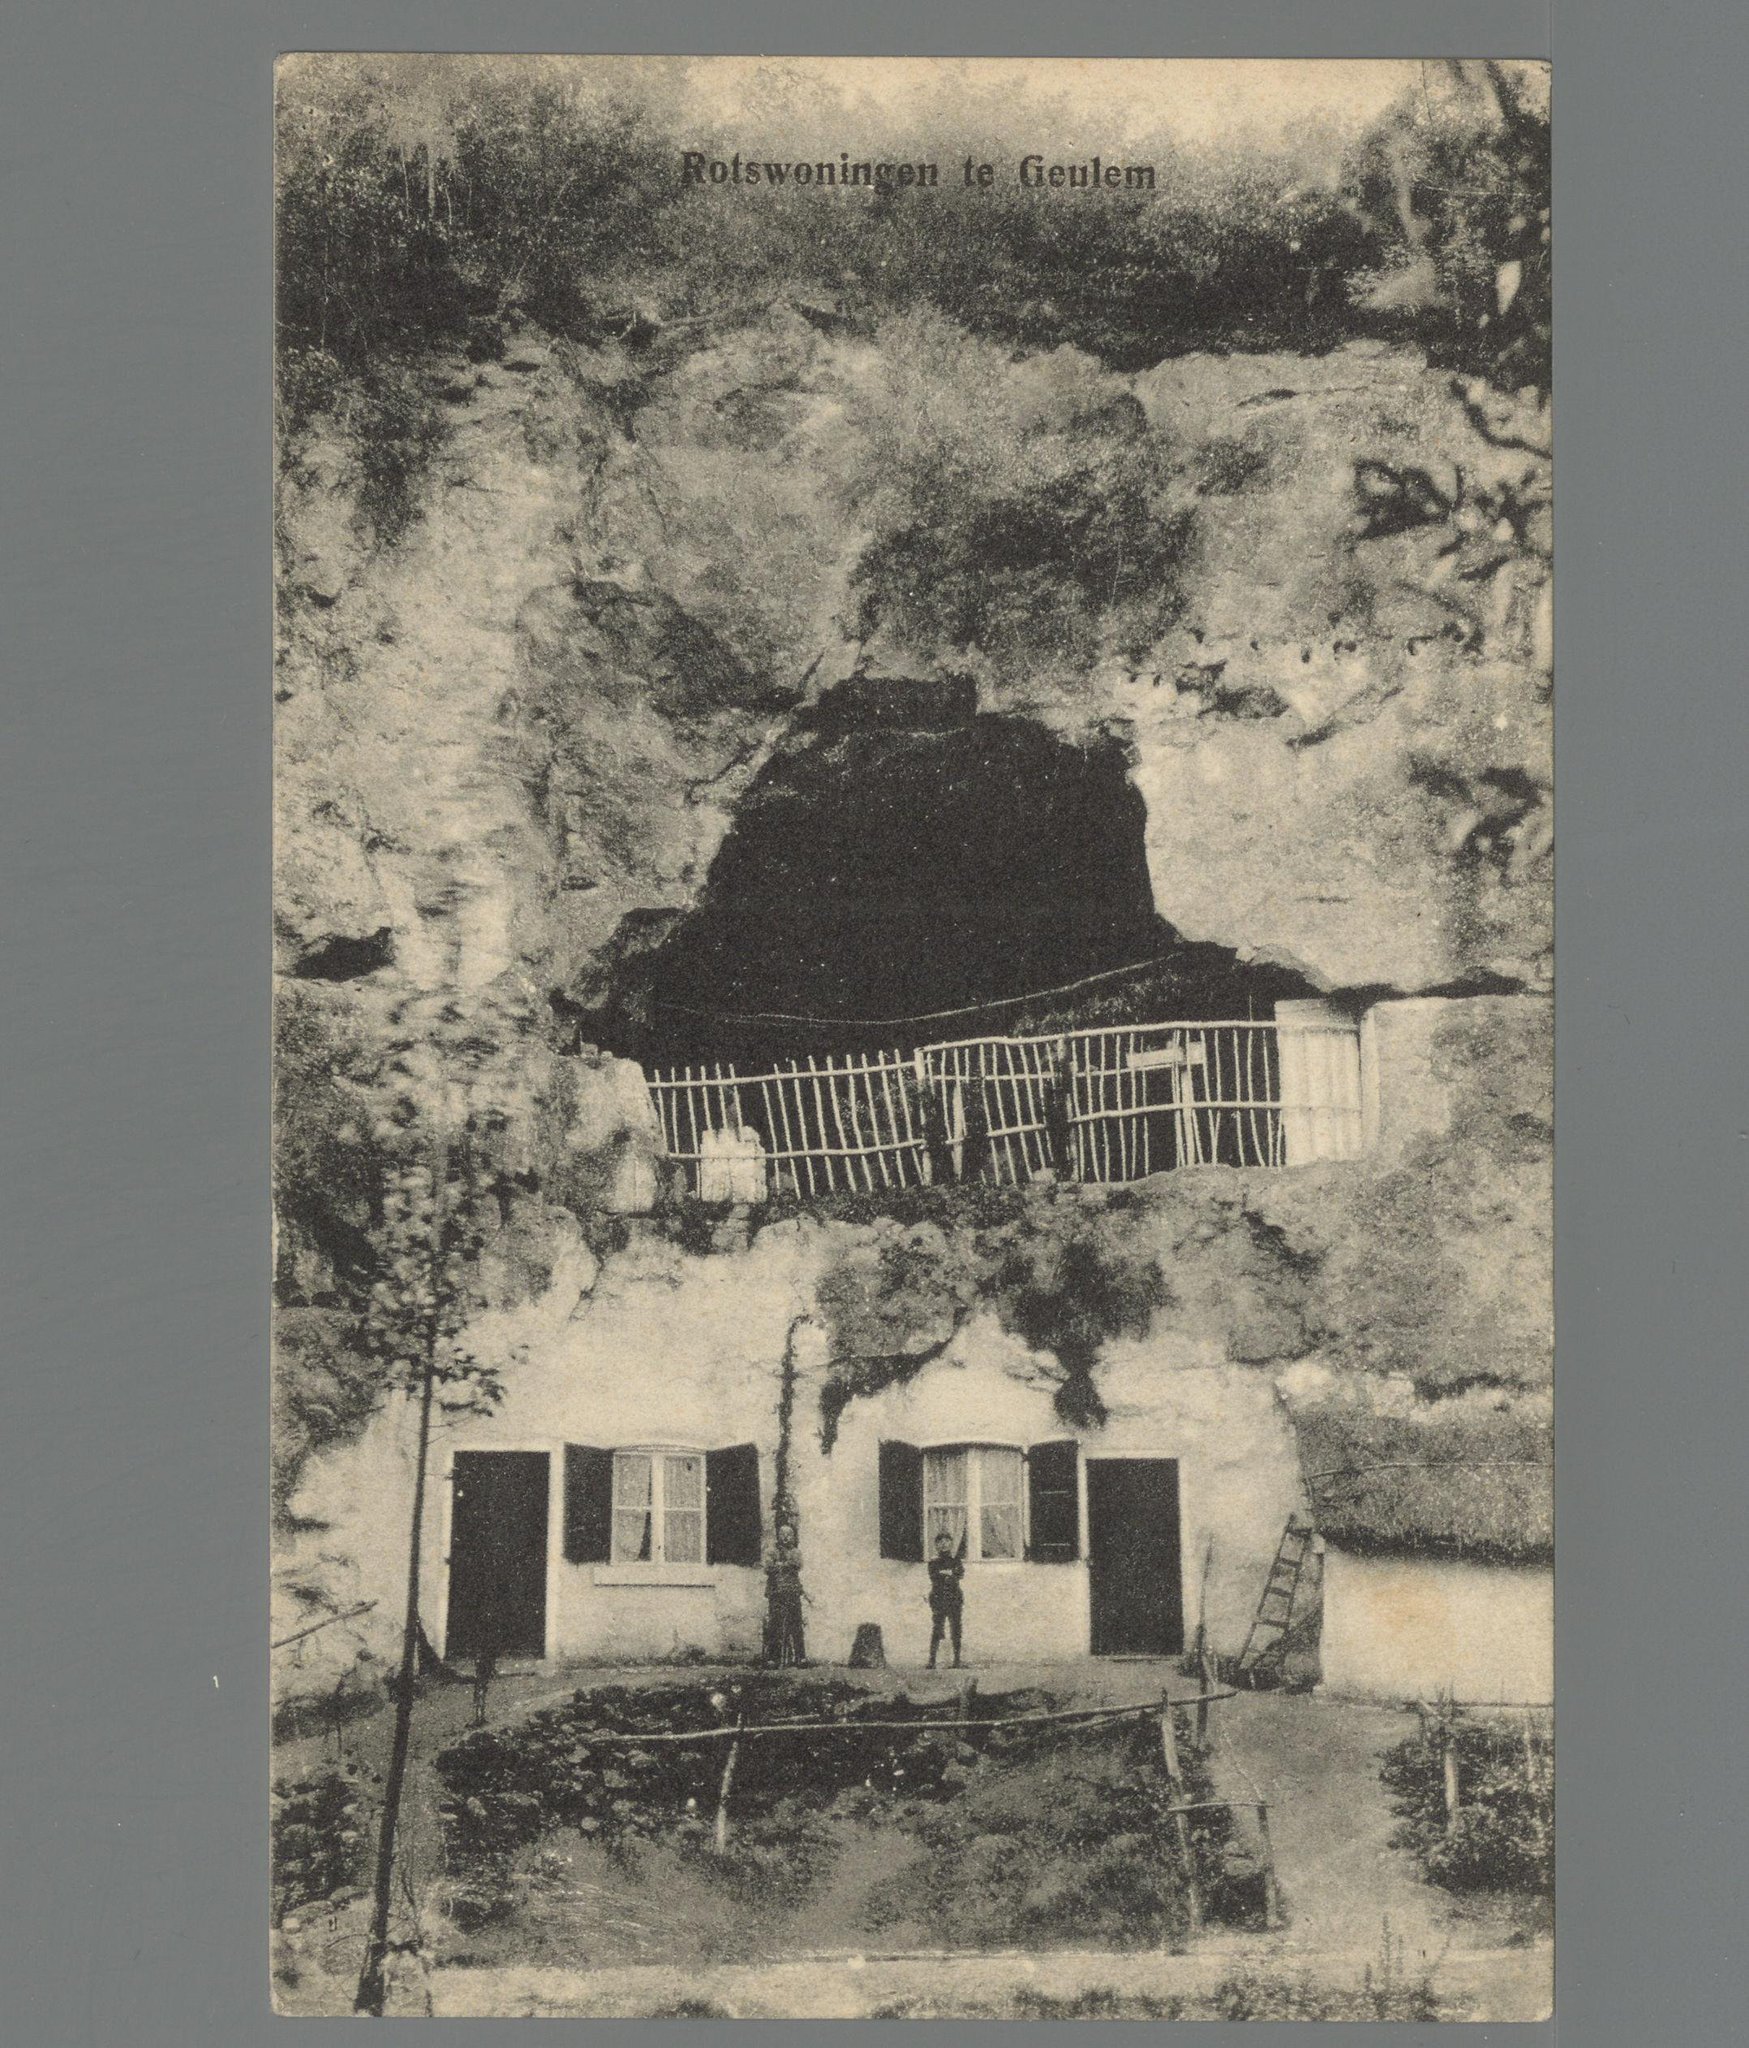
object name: photomechanical print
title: Rotswoningen te Geulem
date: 1905-1926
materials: cardboard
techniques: photograph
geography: geulhem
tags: housing, cave, grotto